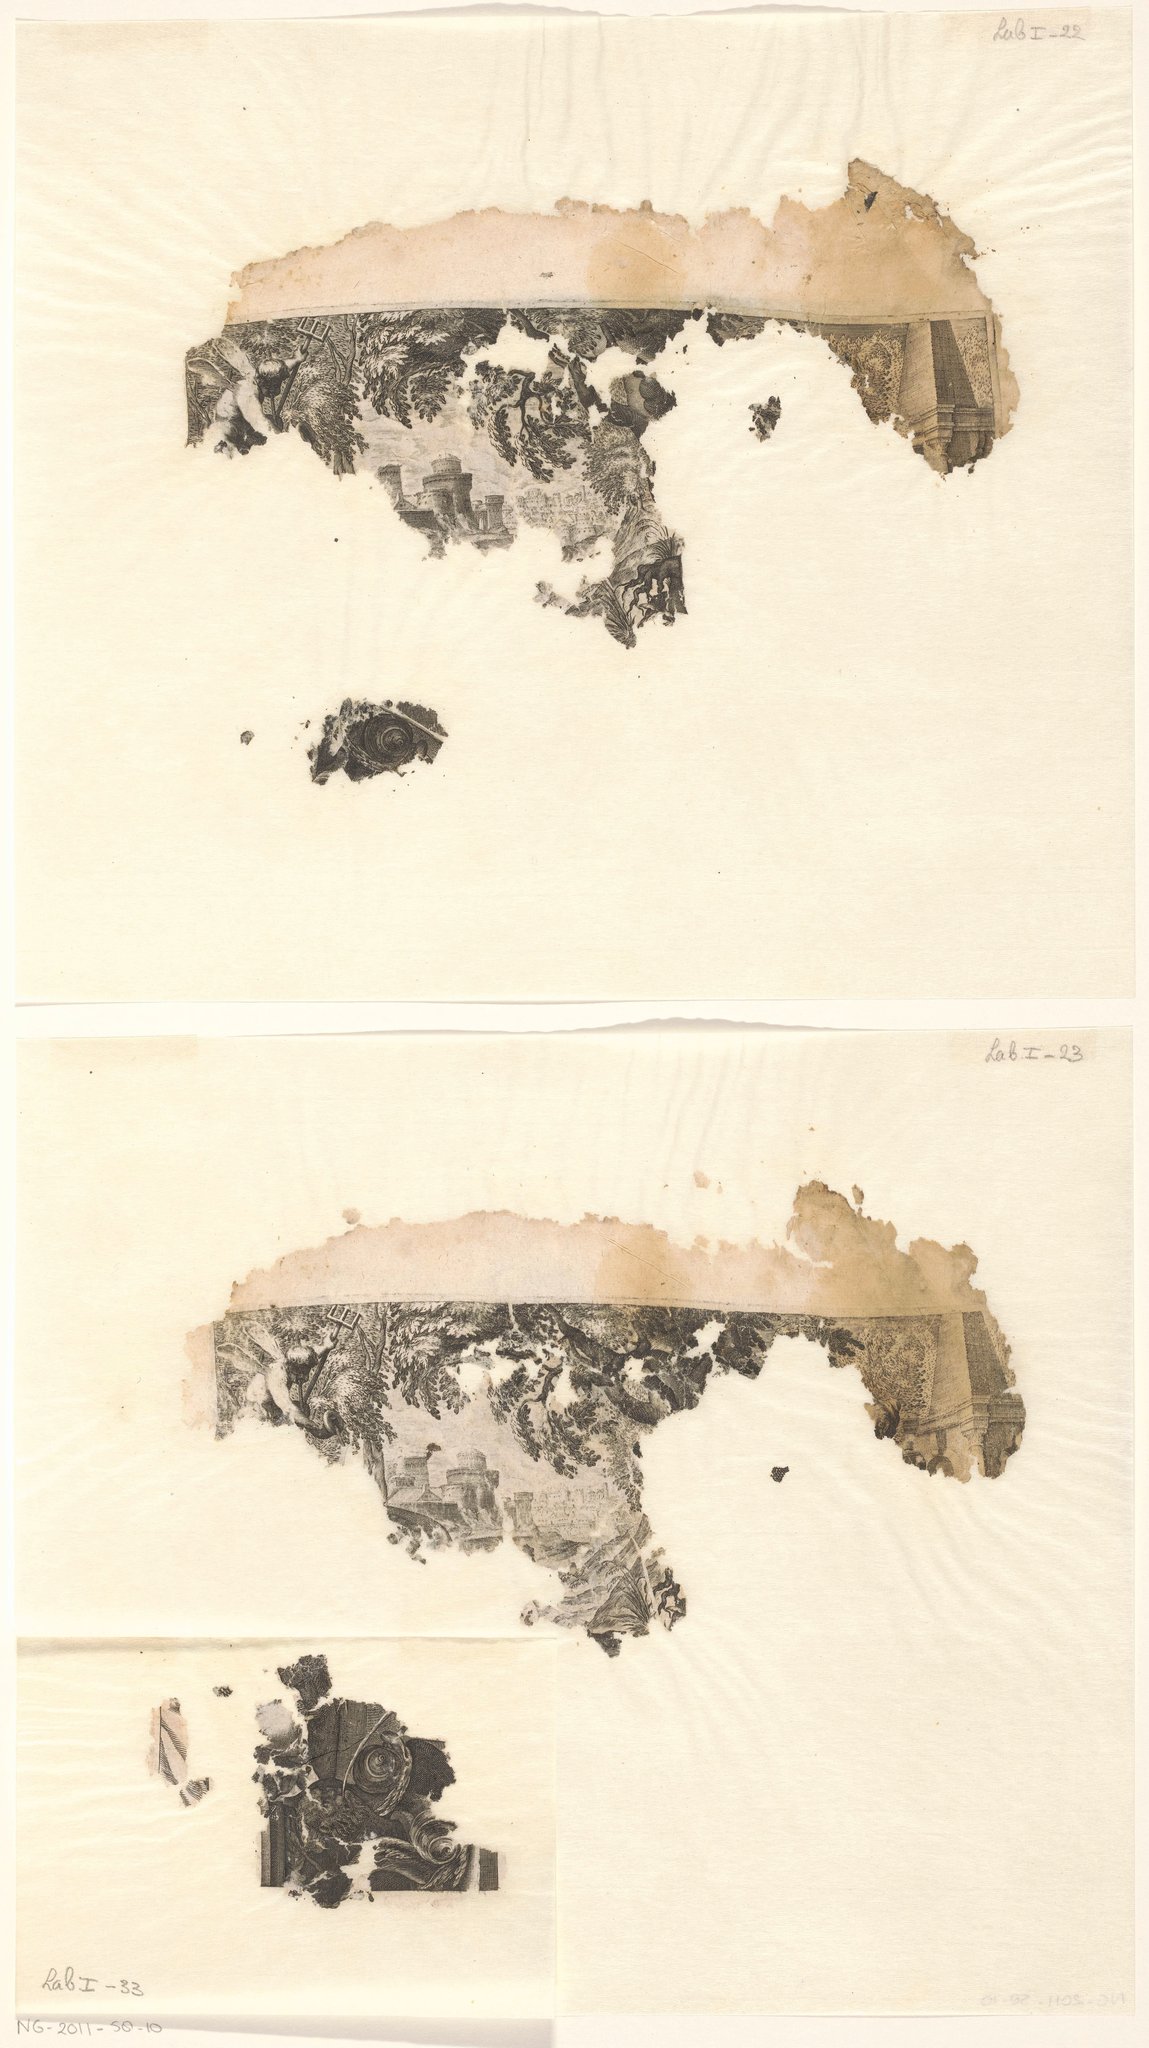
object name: print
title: Losse fragmenten van prenten van Pyramus en Thisbe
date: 1580-1596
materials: paper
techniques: engraving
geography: northern netherlands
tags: thisbe kills herself with pyramus' sword (the scene may be represented near a fountain)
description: De prenten in de Nova Zembla collectie zijn tijdens een expeditie van Willem Barendsz en Jacob van Heemskerk in 1596-1597 noodgedwongen in het winterkamp, het ‘Behouden Huis’, op het eiland achtergelaten. De prenten waren in één of meerdere stapels als handelswaar meegenomen vanuit Amsterdam. Bijna drie eeuwen later, in 1871, keerde de Noor Elling Carlsen terug naar Nova Zembla en vond daar de restanten van het ‘Behouden Huis, inclusief een groot deel van de inventaris. Een deel van de prenten, in de vorm van aaneengekoekte kluiten, werd toen ook teruggevonden. De papierkluiten waren soms op meerdere plekken gebroken. Tussen 1975-1979 zijn de prenten van elkaar gescheiden. Dit leverde in totaal ca. 1000 fragmenten van ca. 400 afdrukken van ca. 150 verschillende prenten op. Voor zover mogelijk zijn de fragmenten samengevoegd en zijn de prenten gereconstrueerd.